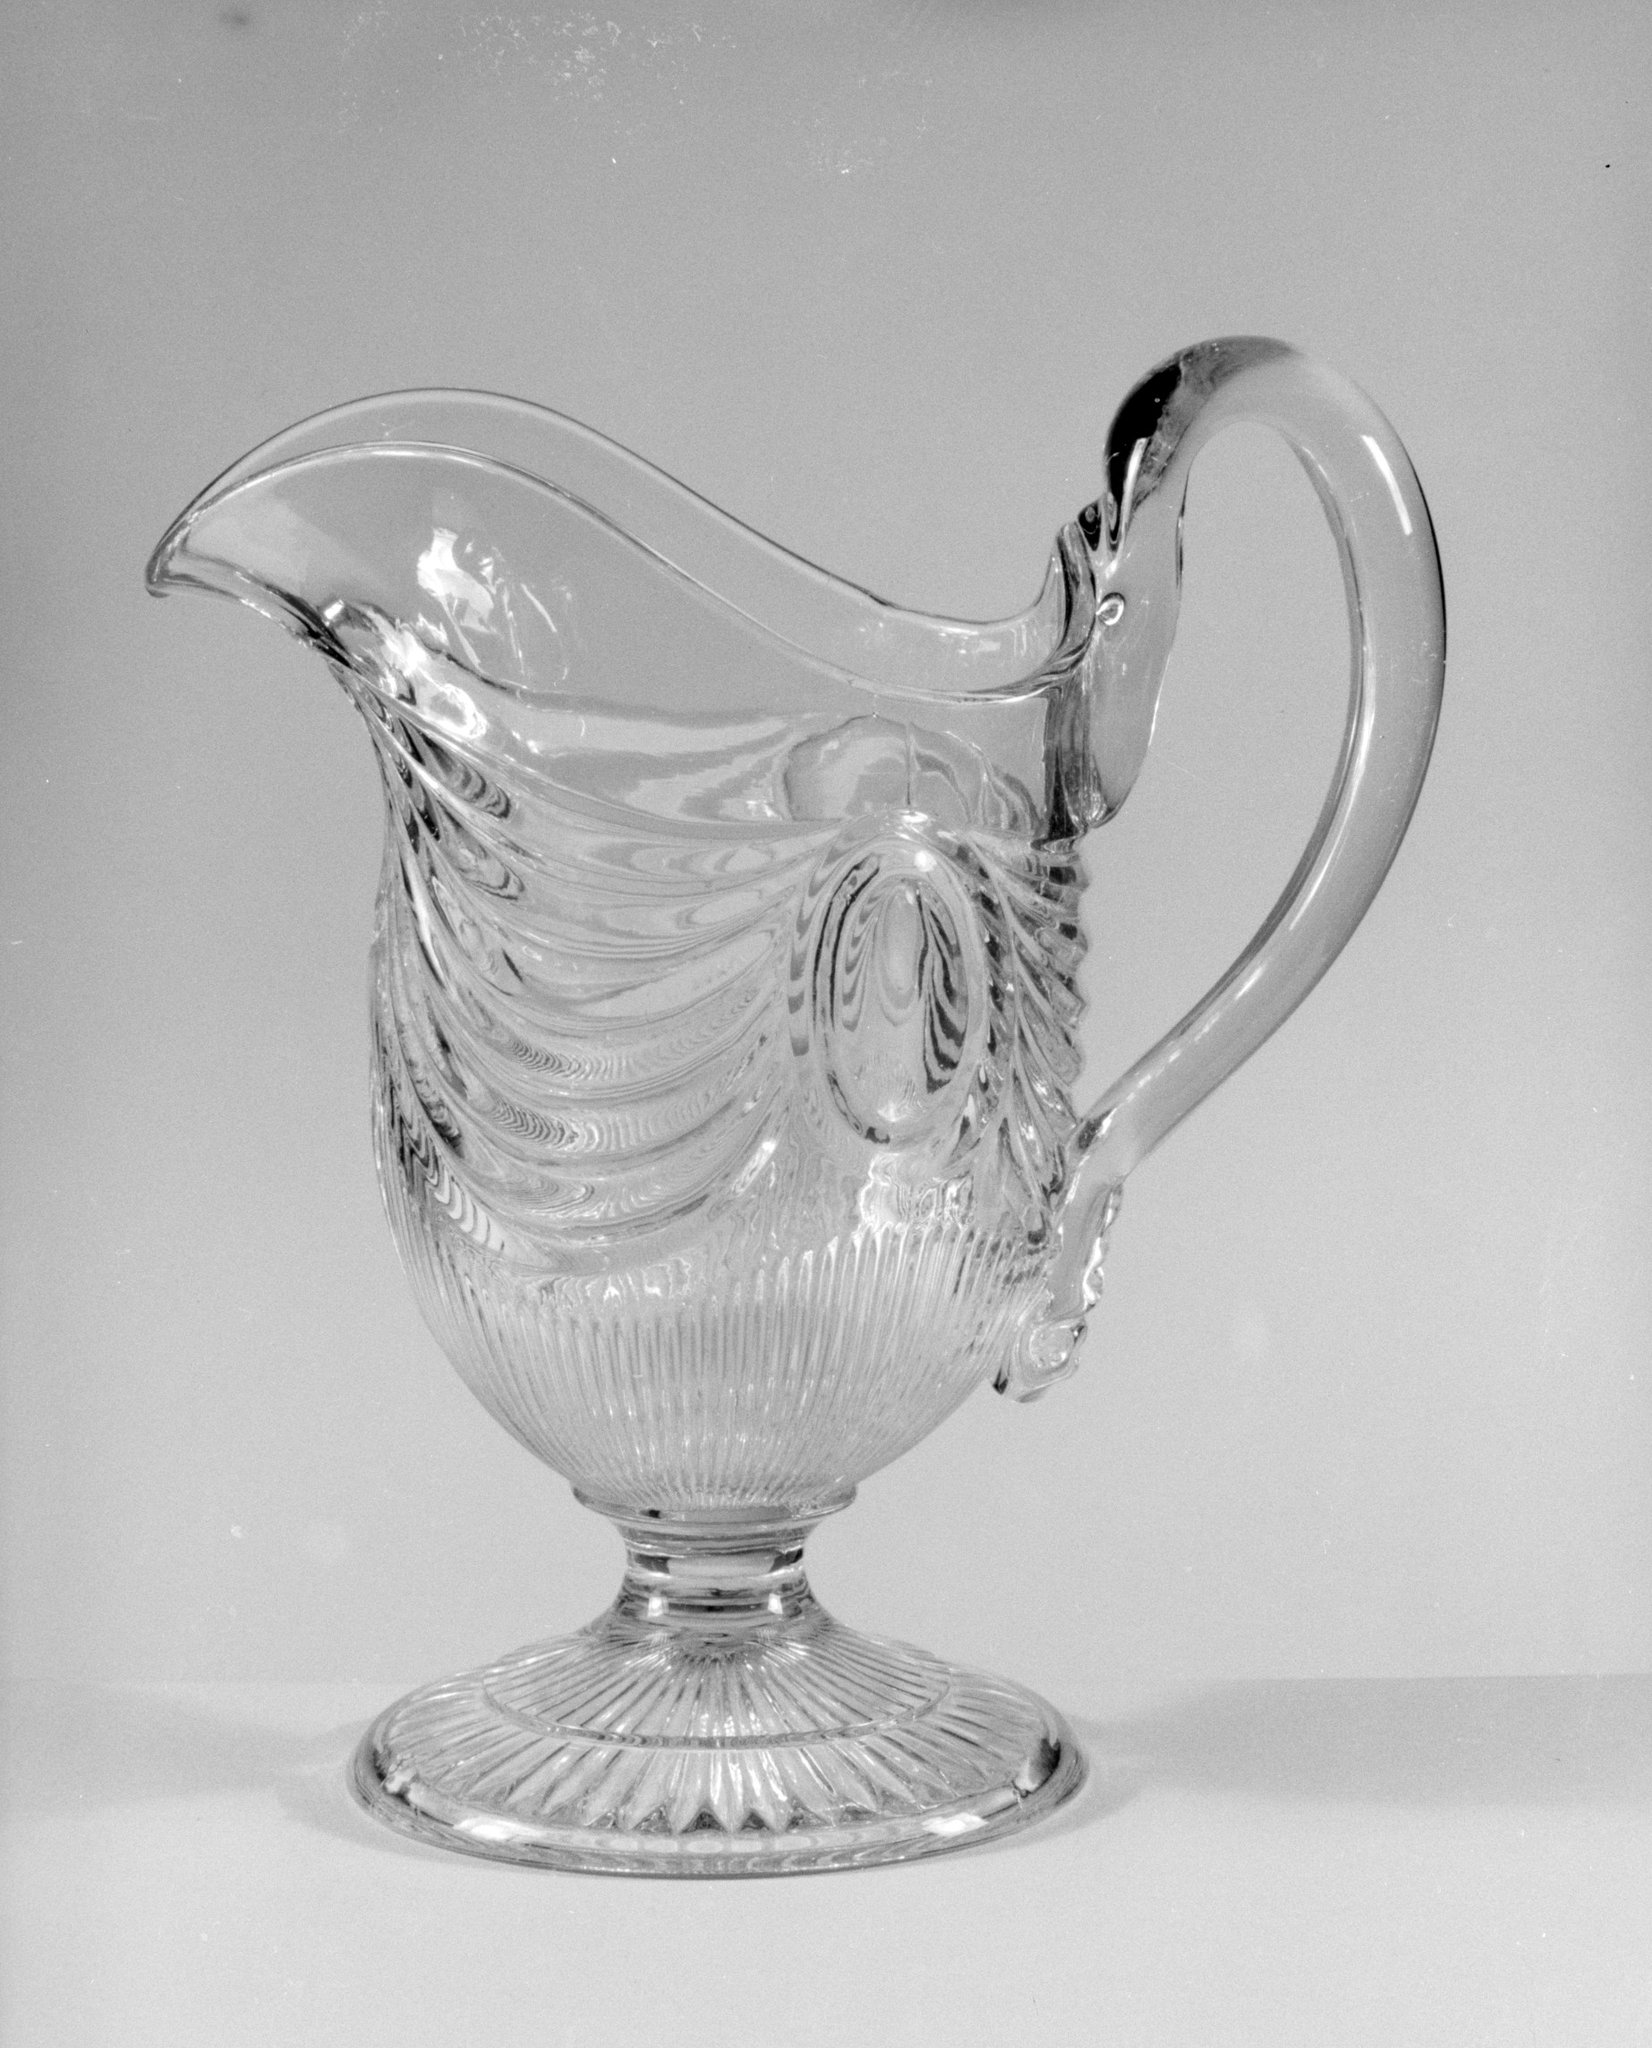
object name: cream pot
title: Creamer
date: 1860-1870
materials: glass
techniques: pressed